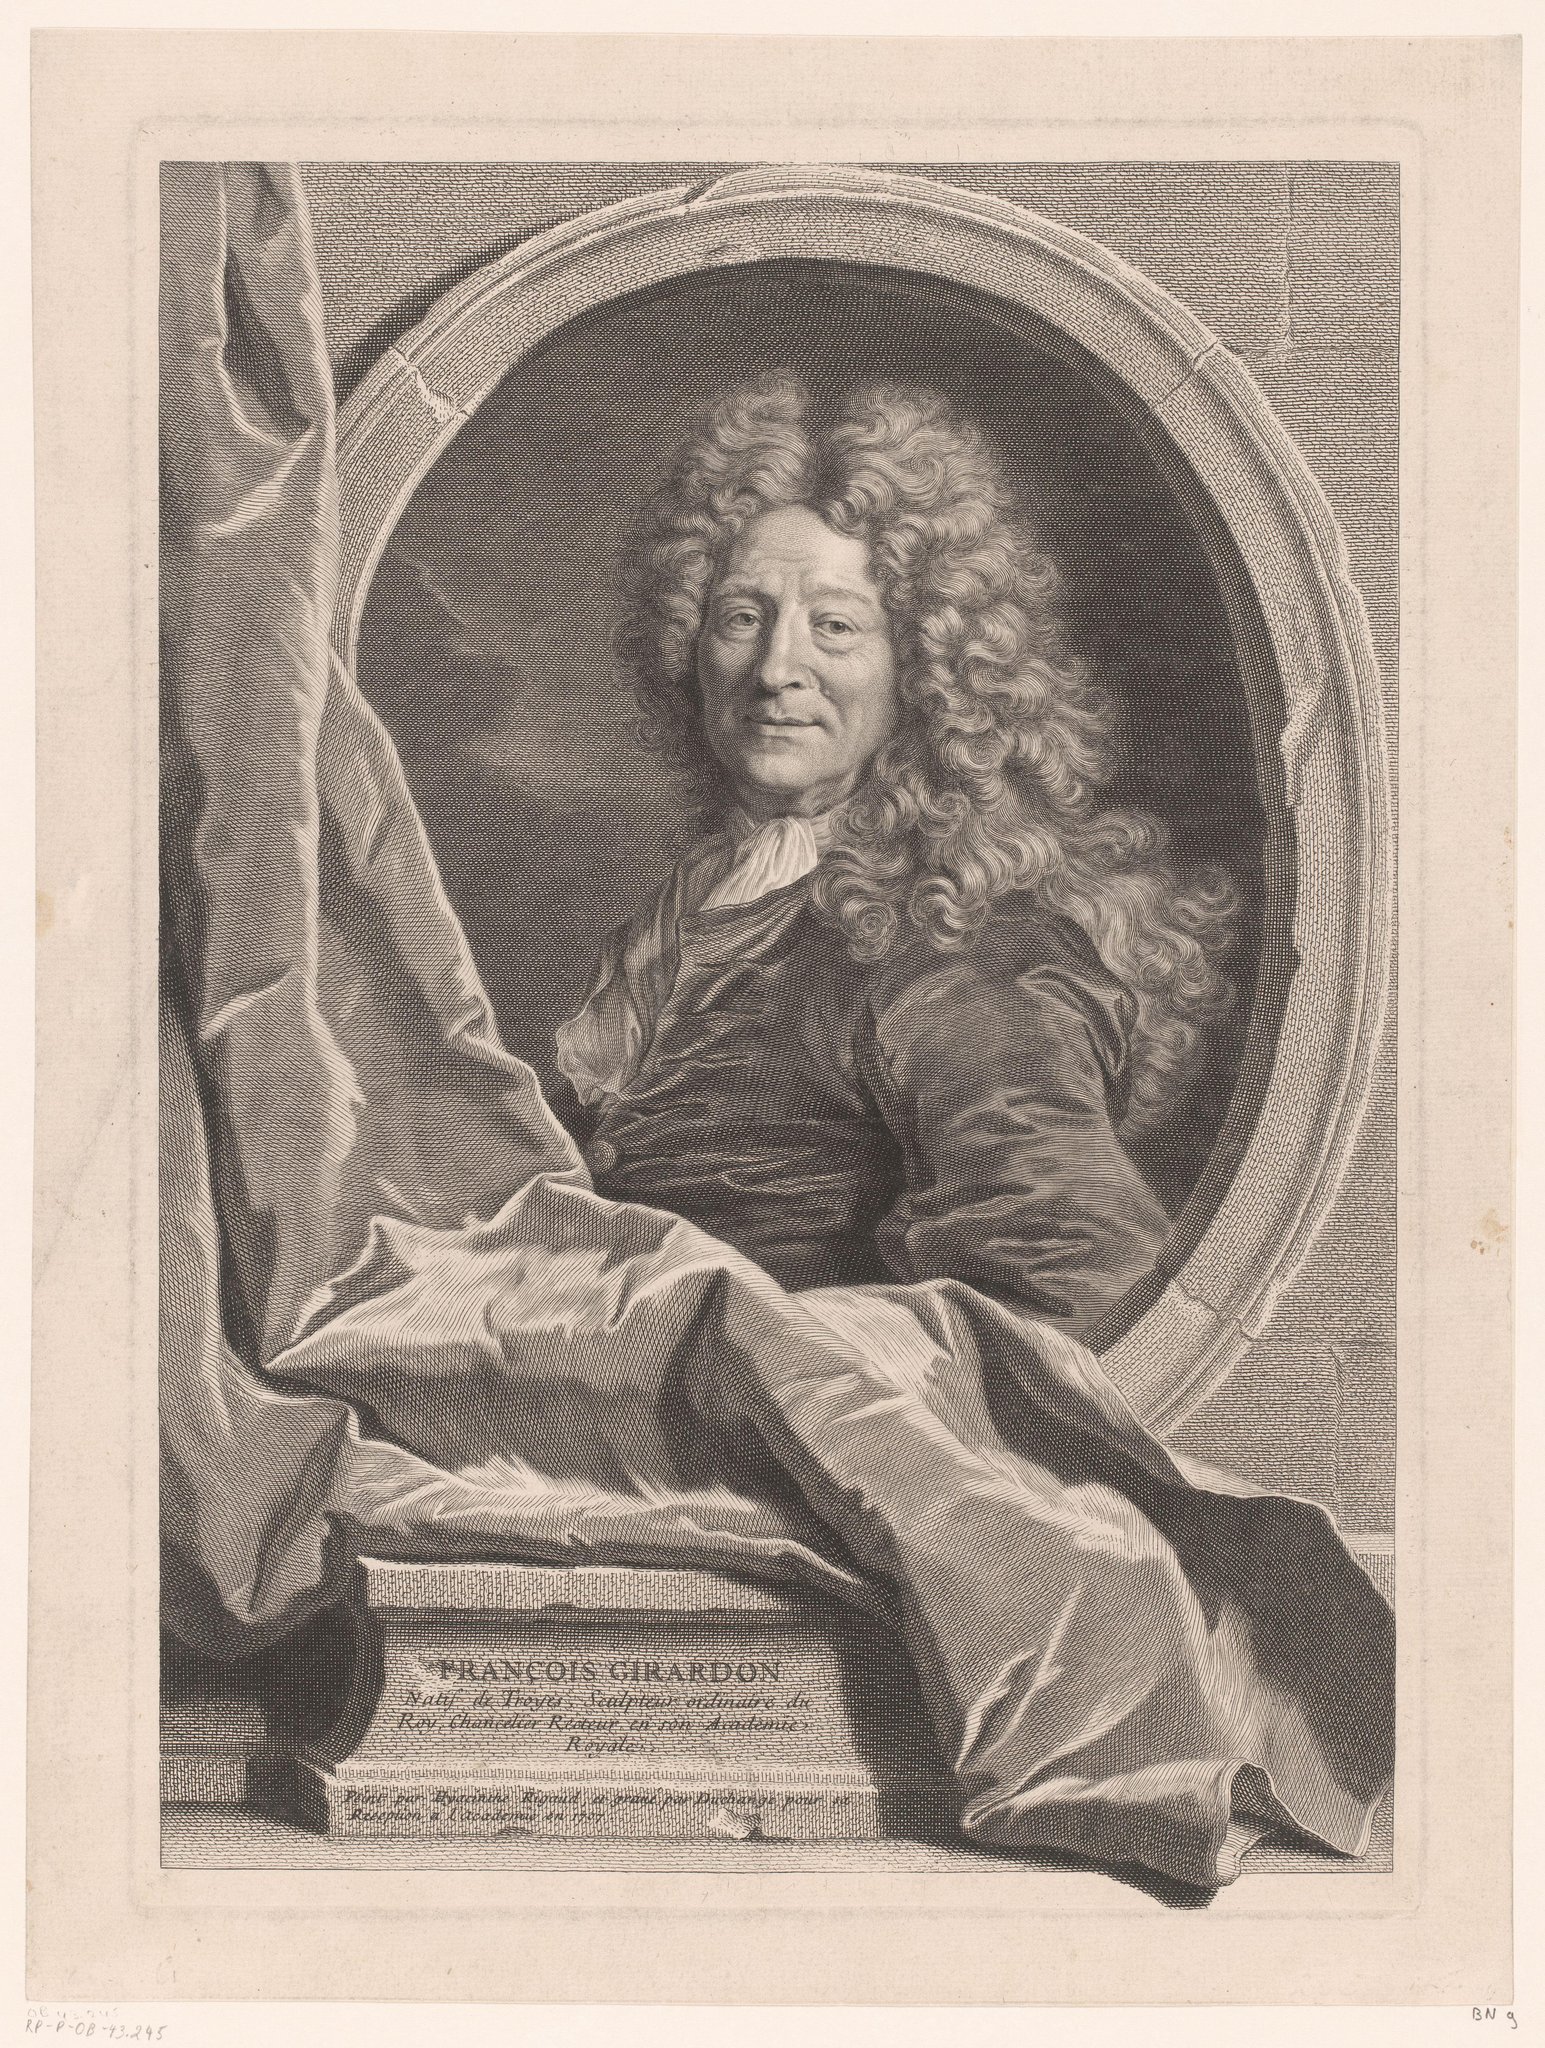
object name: print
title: François Girardon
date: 1707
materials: paper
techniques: engraving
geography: france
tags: paris, françois girardon, ornament ~ medallion, historical persons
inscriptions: collector's mark: Lugt 240